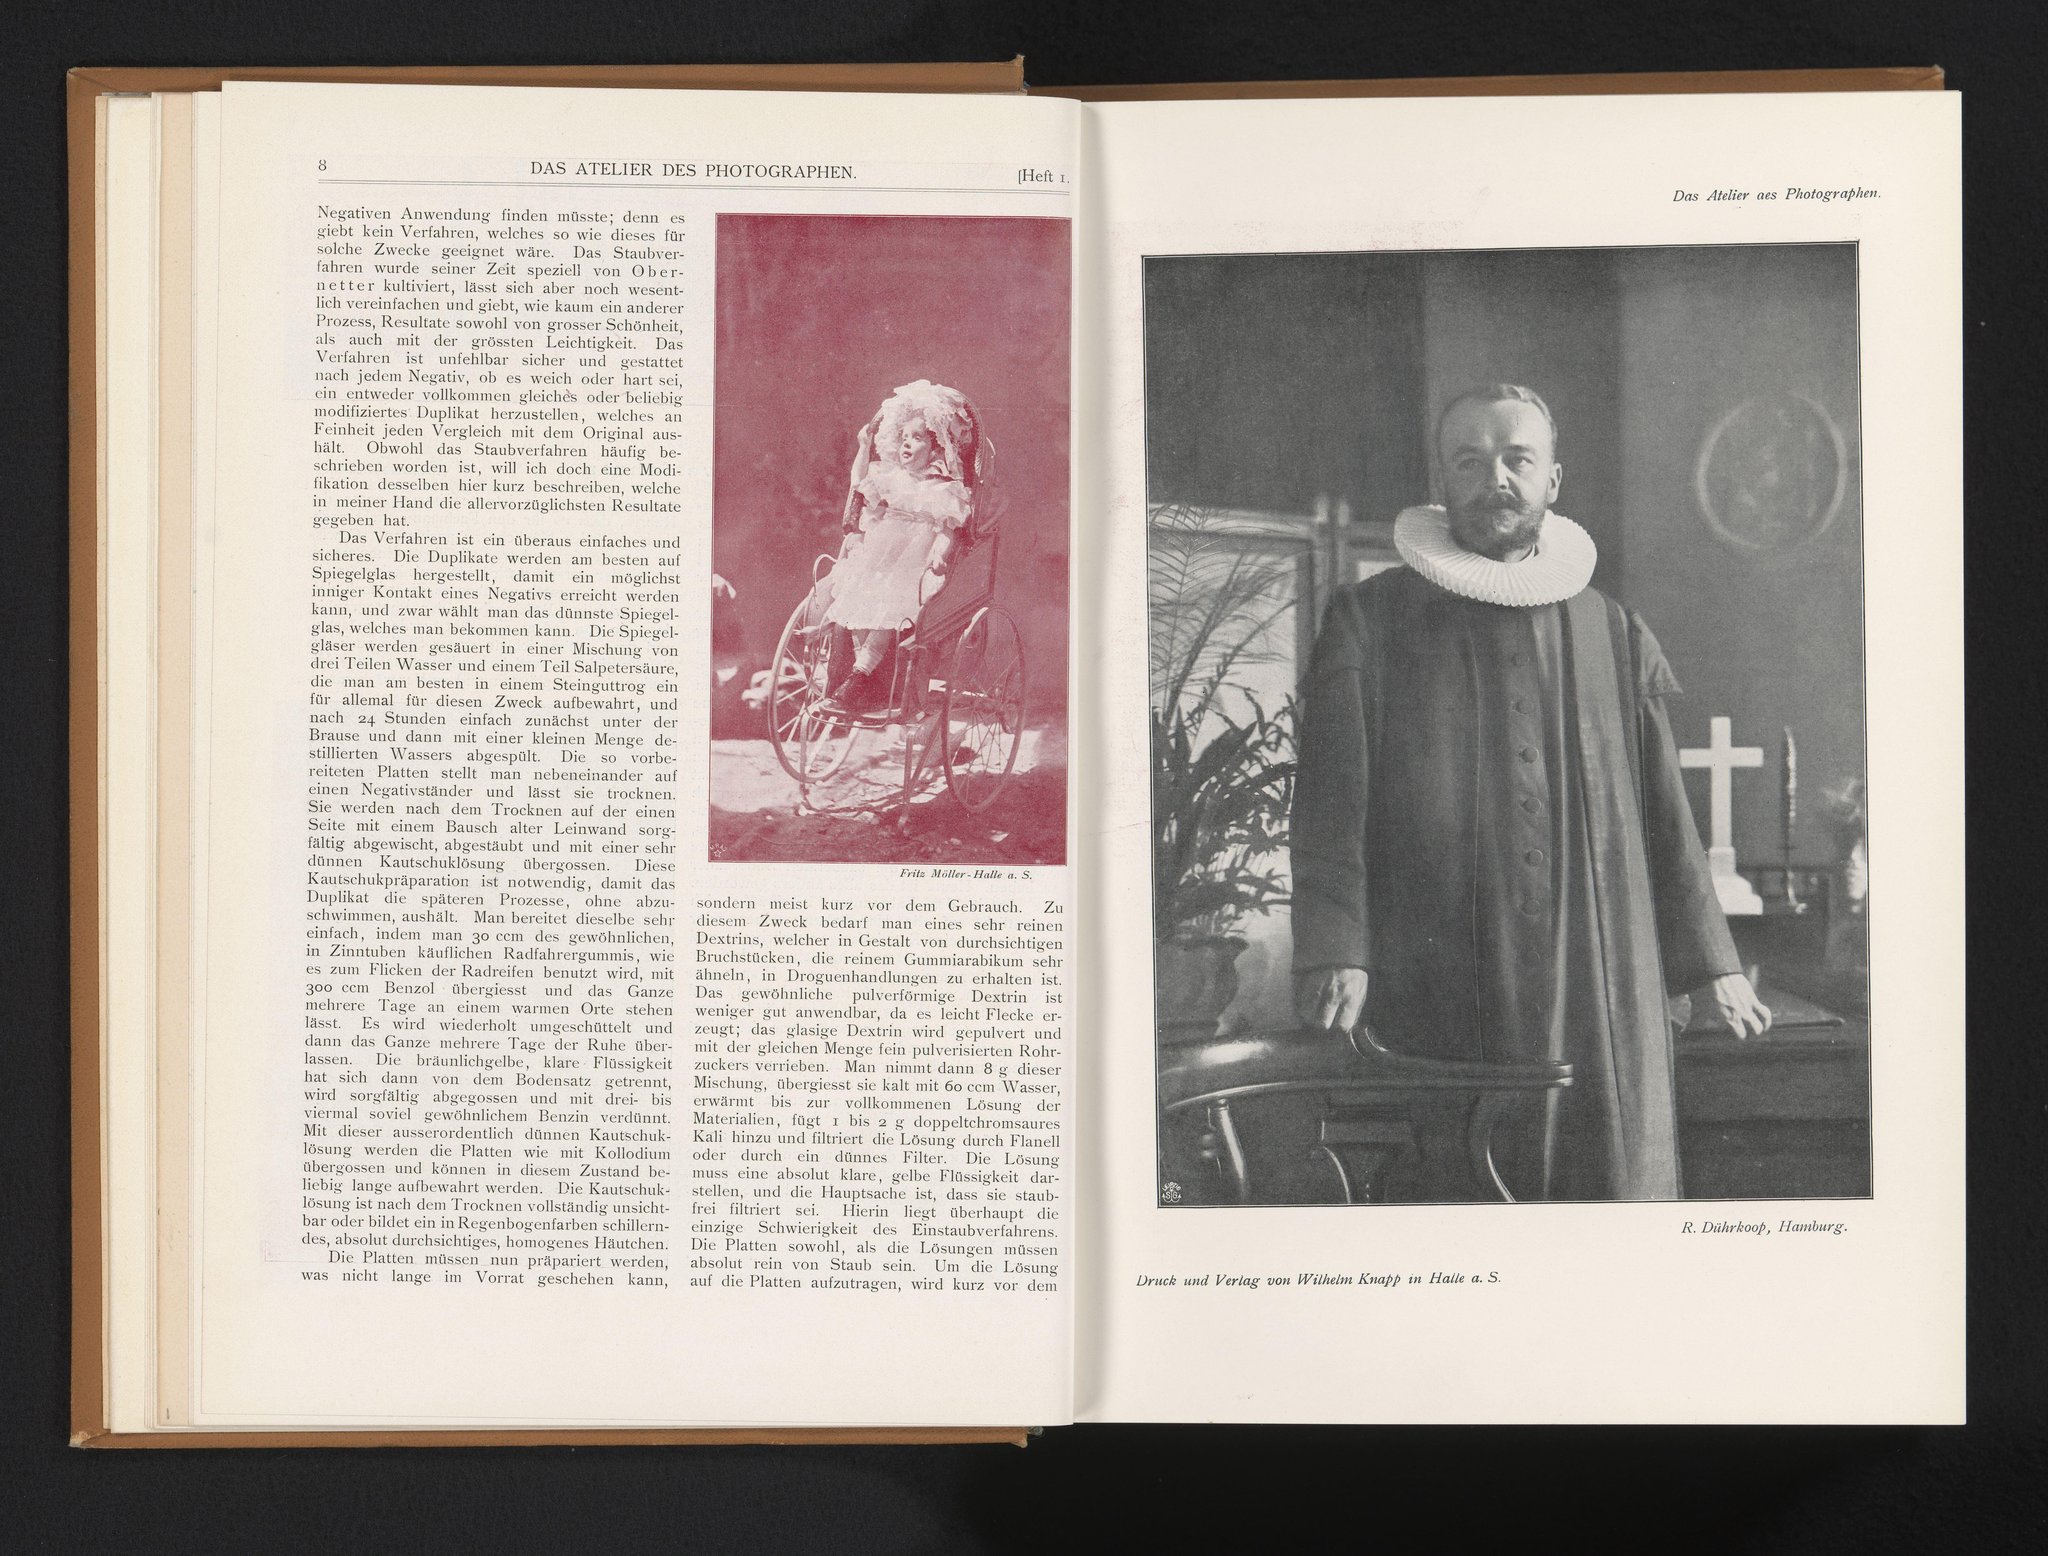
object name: page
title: Portret van een onbekende man met kraag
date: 1895-1900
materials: paper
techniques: autotype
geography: halle an der saale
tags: historical persons, neck-gear: collar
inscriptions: inscription: ‘Das Atelier aes Photographen.’, monogram: ‘LEIPZIG/ S G’